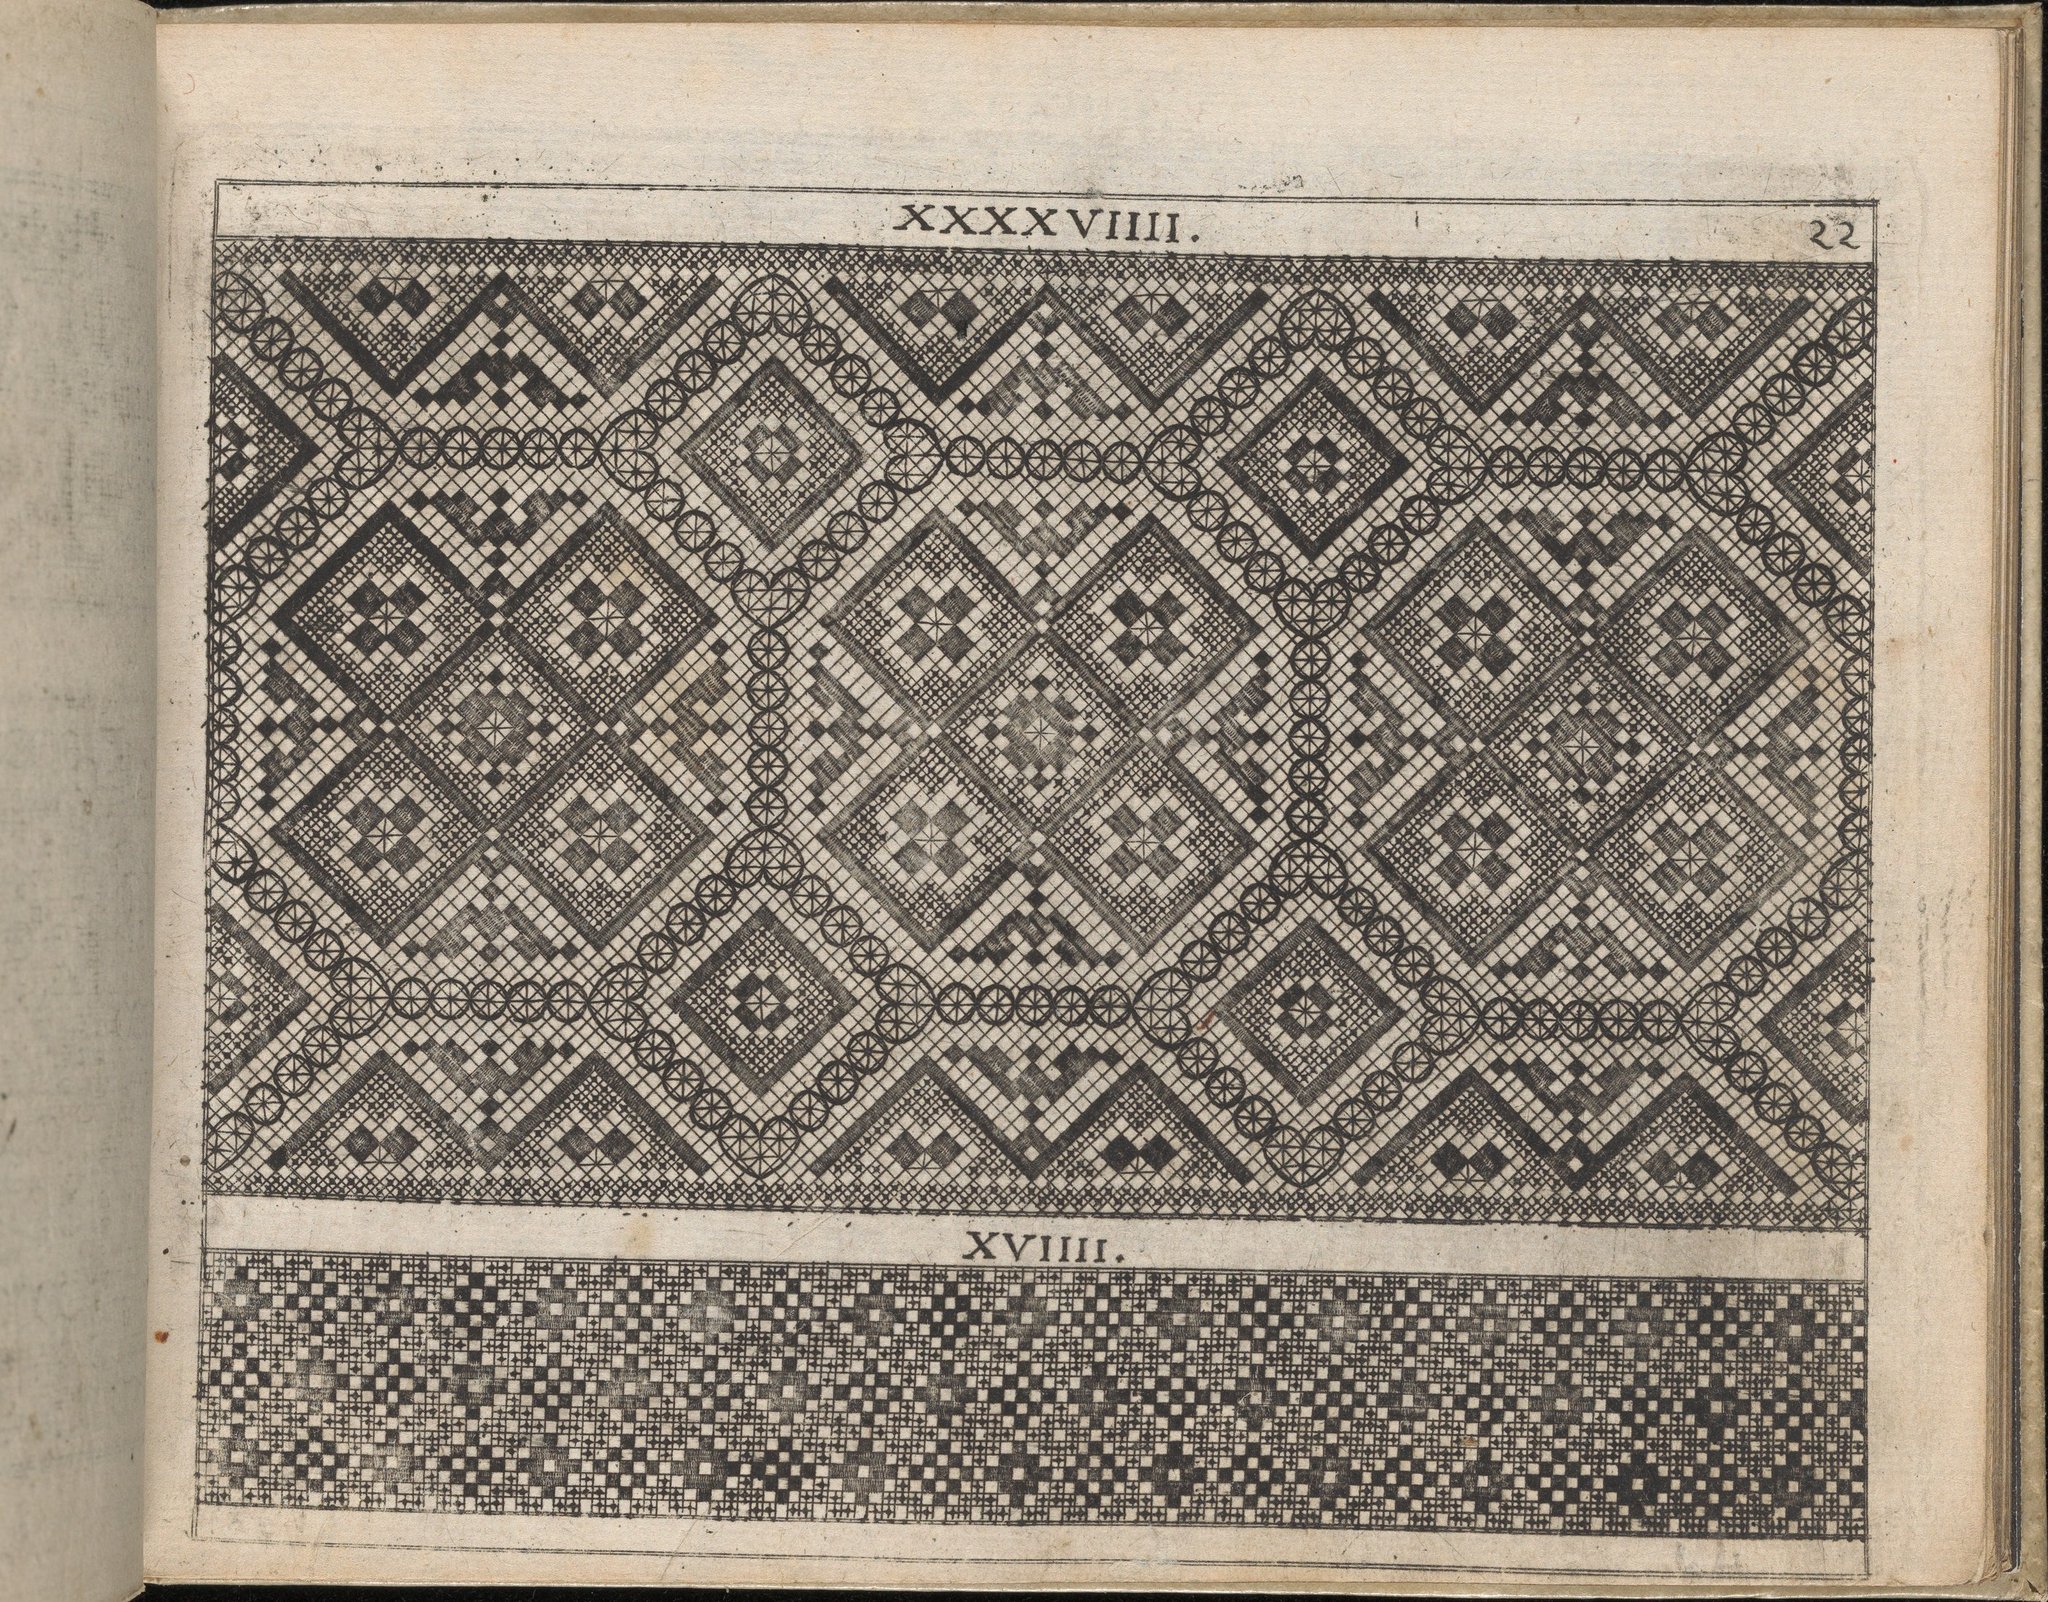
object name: book print ornament architecture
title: Newes Modelbuch in Kupffer (Page 31r)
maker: johann sibmacher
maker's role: artist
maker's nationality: german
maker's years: 1590-1611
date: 1604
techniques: etching